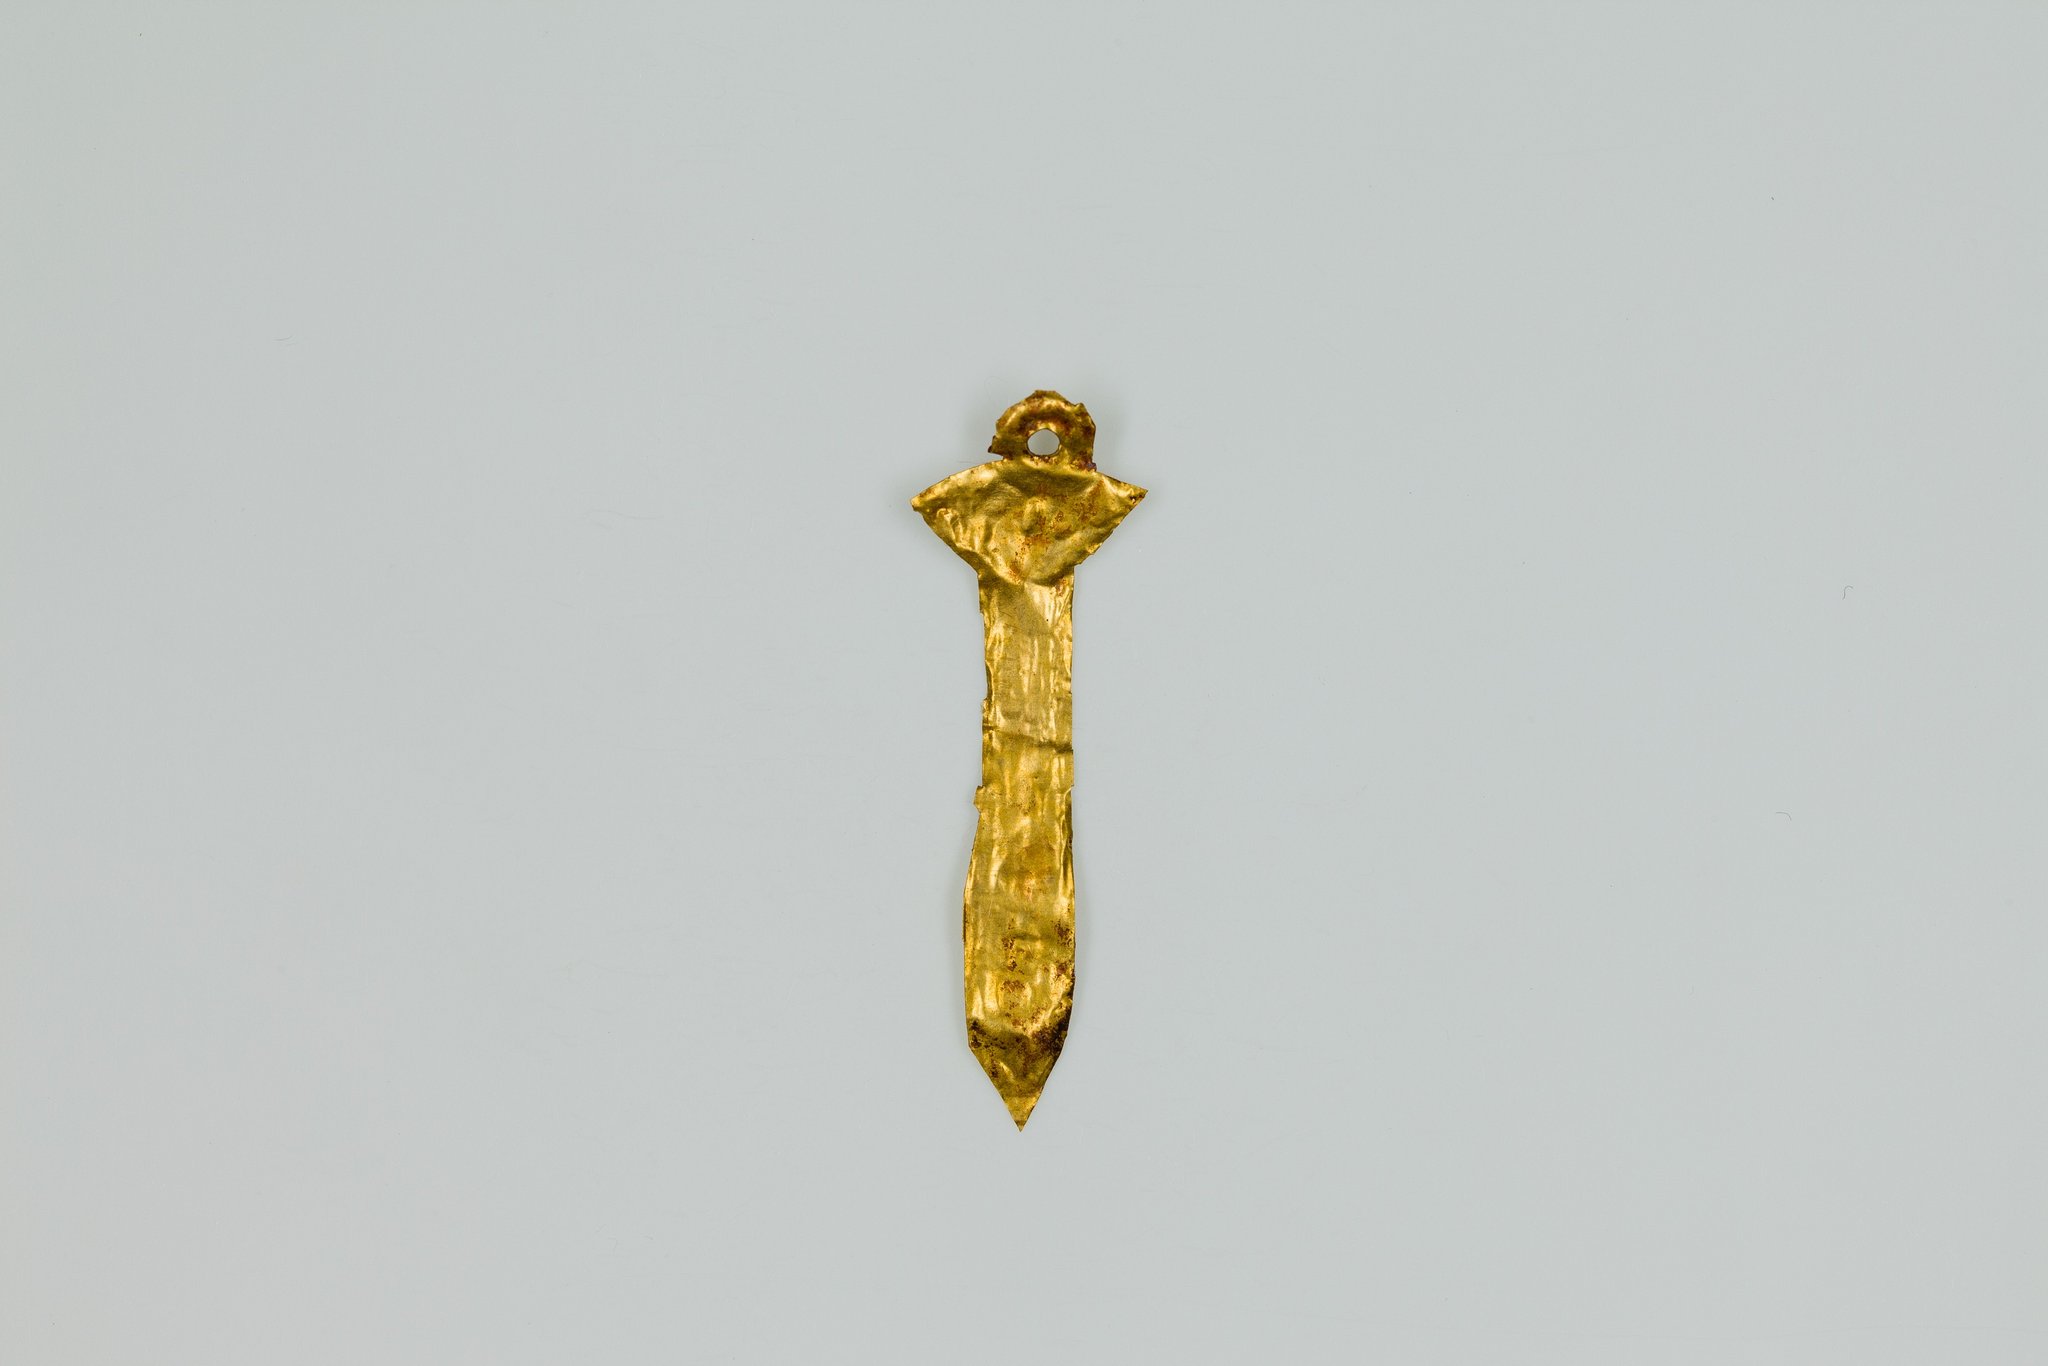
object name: amulet, papyrus scepter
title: Papyrus scepter (wadj) amulet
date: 664-380 BCE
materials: gold